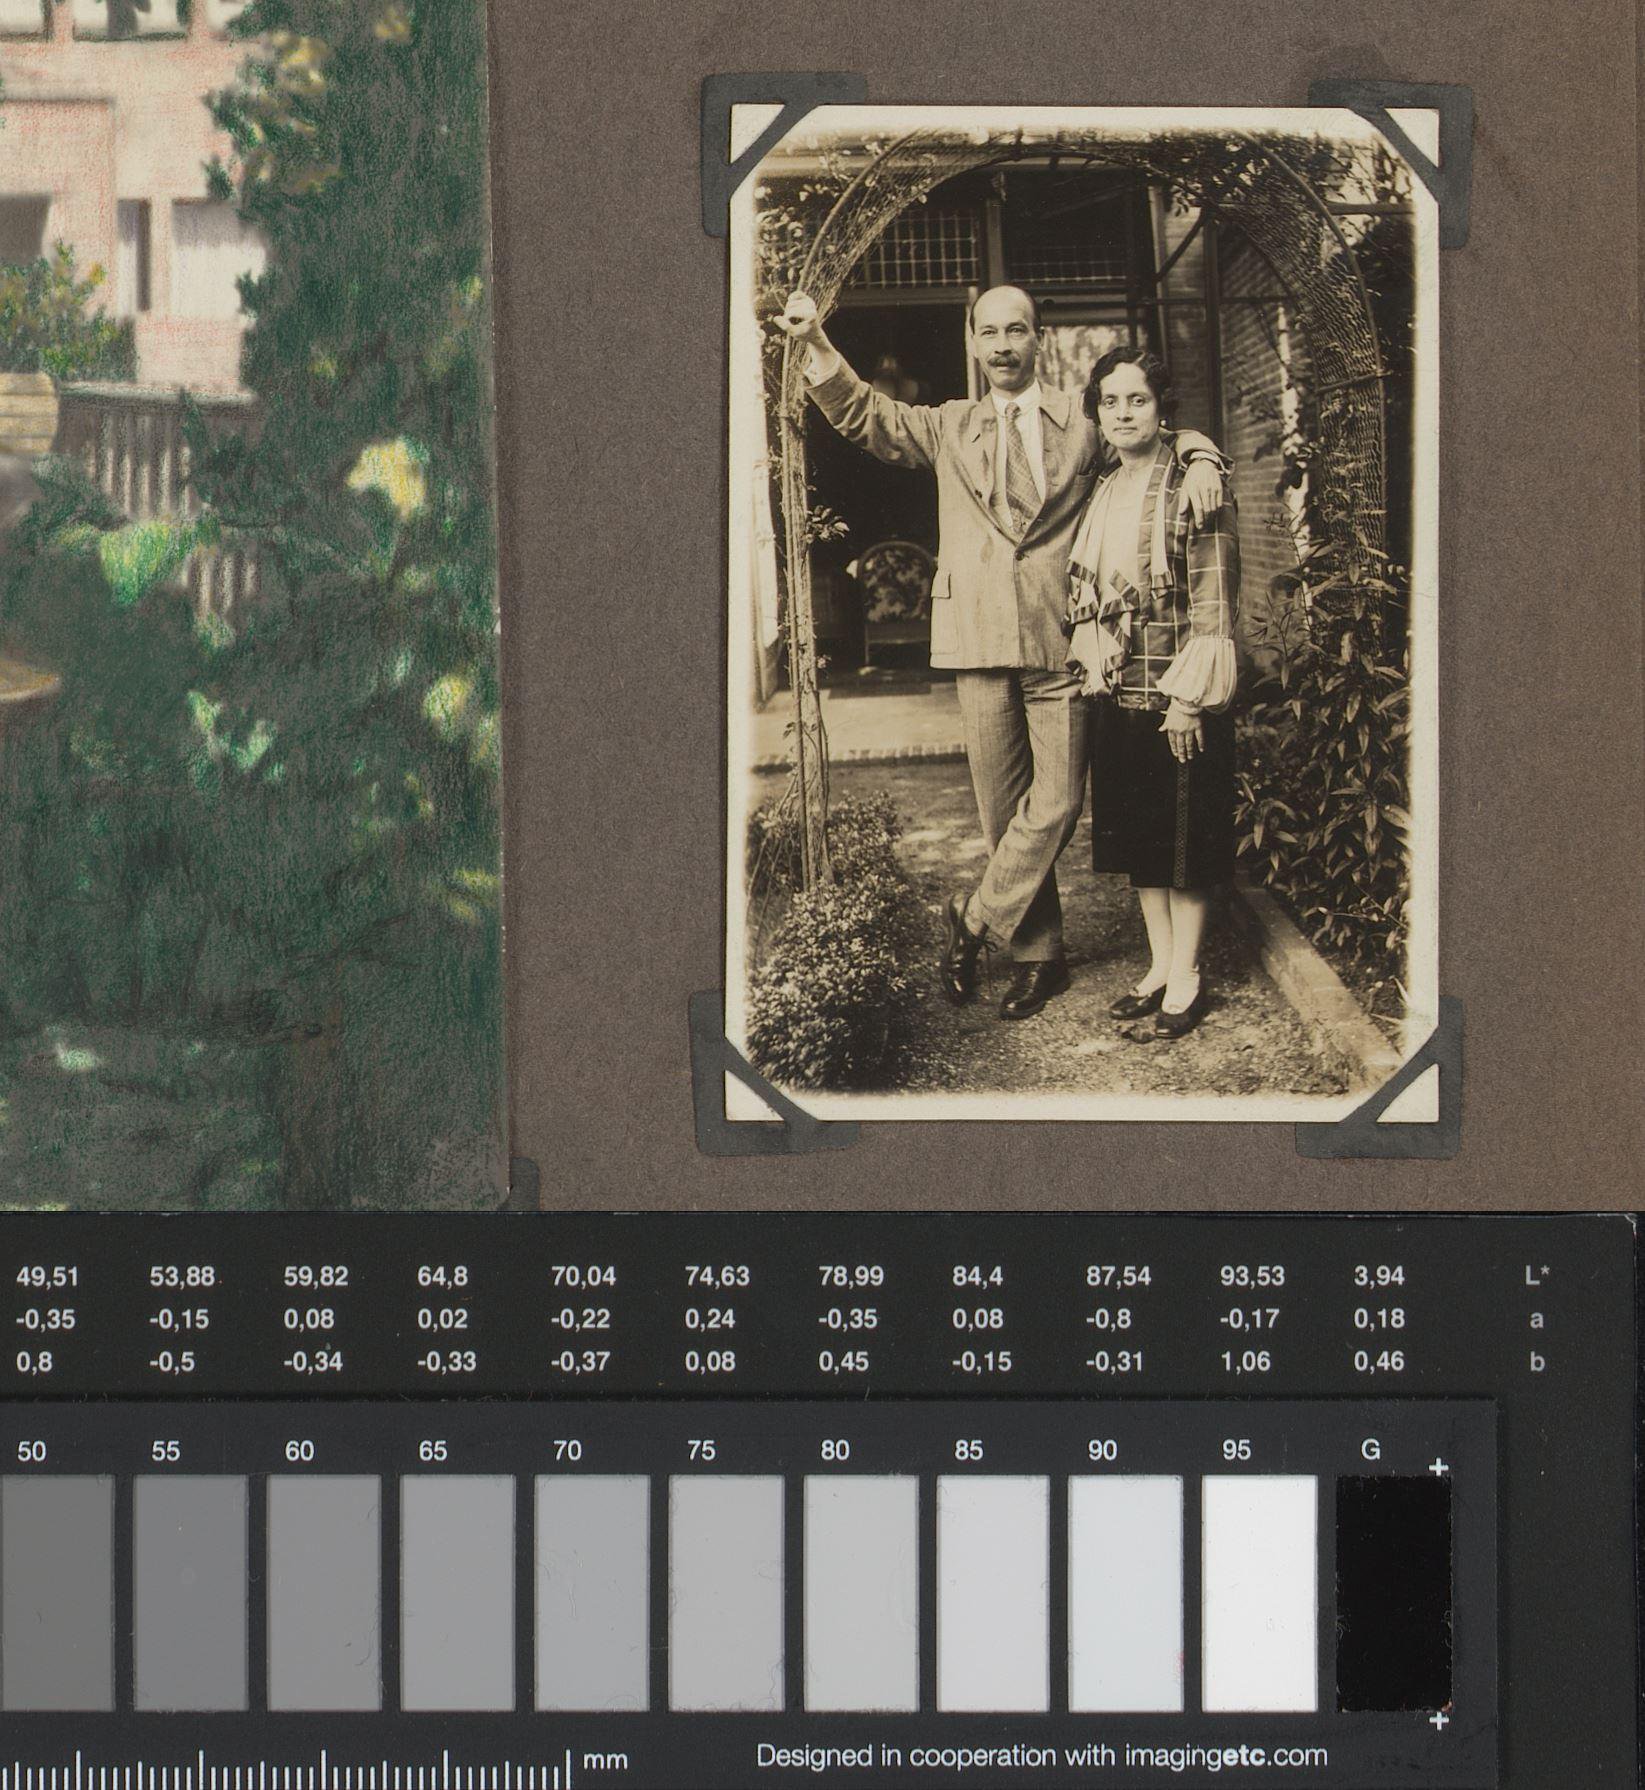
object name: photograph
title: Meinard Dorus Mijer en Henriëtte Wassink staand in tuin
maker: Anonymous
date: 1930-1935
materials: paper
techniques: gelatin silver print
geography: netherlands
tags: batavia, the hague, henriëtte wassink, engineer, garden, couple of lovers, netherlands